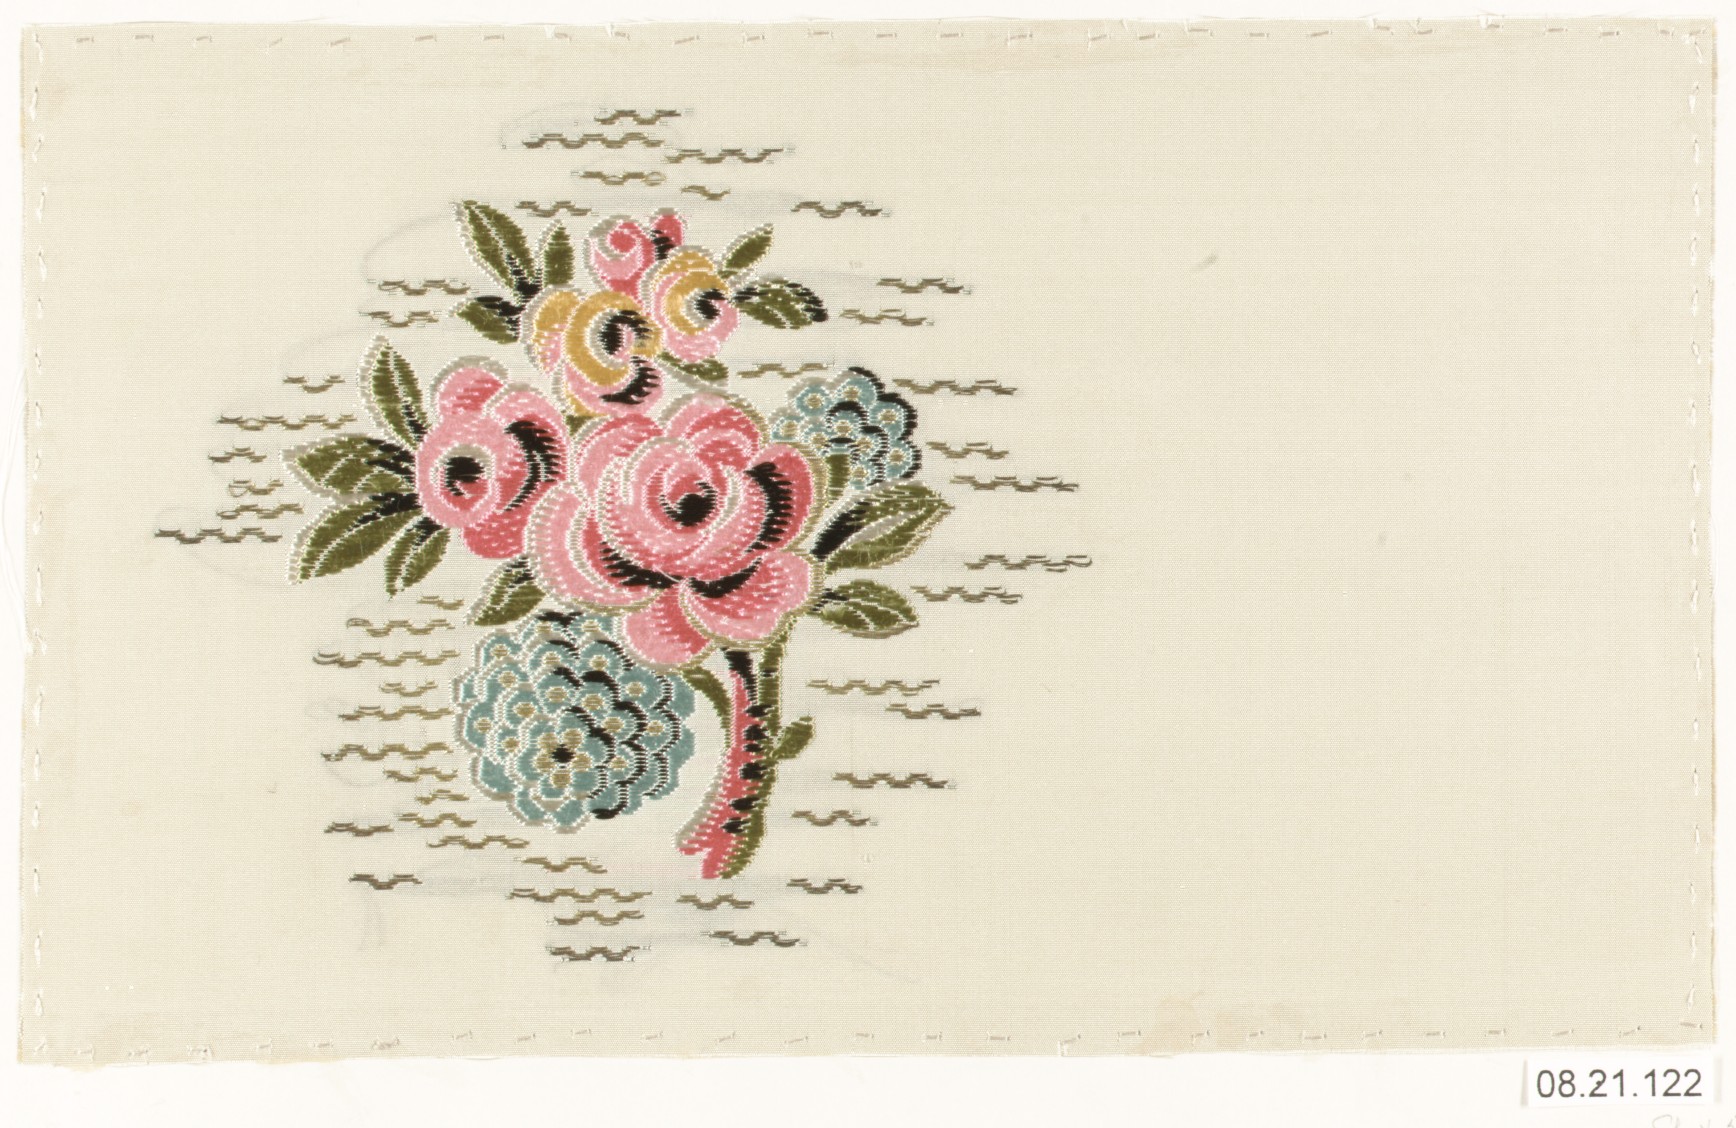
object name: textile sample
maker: Anonymous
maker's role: designer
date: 1900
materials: silk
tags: flowers